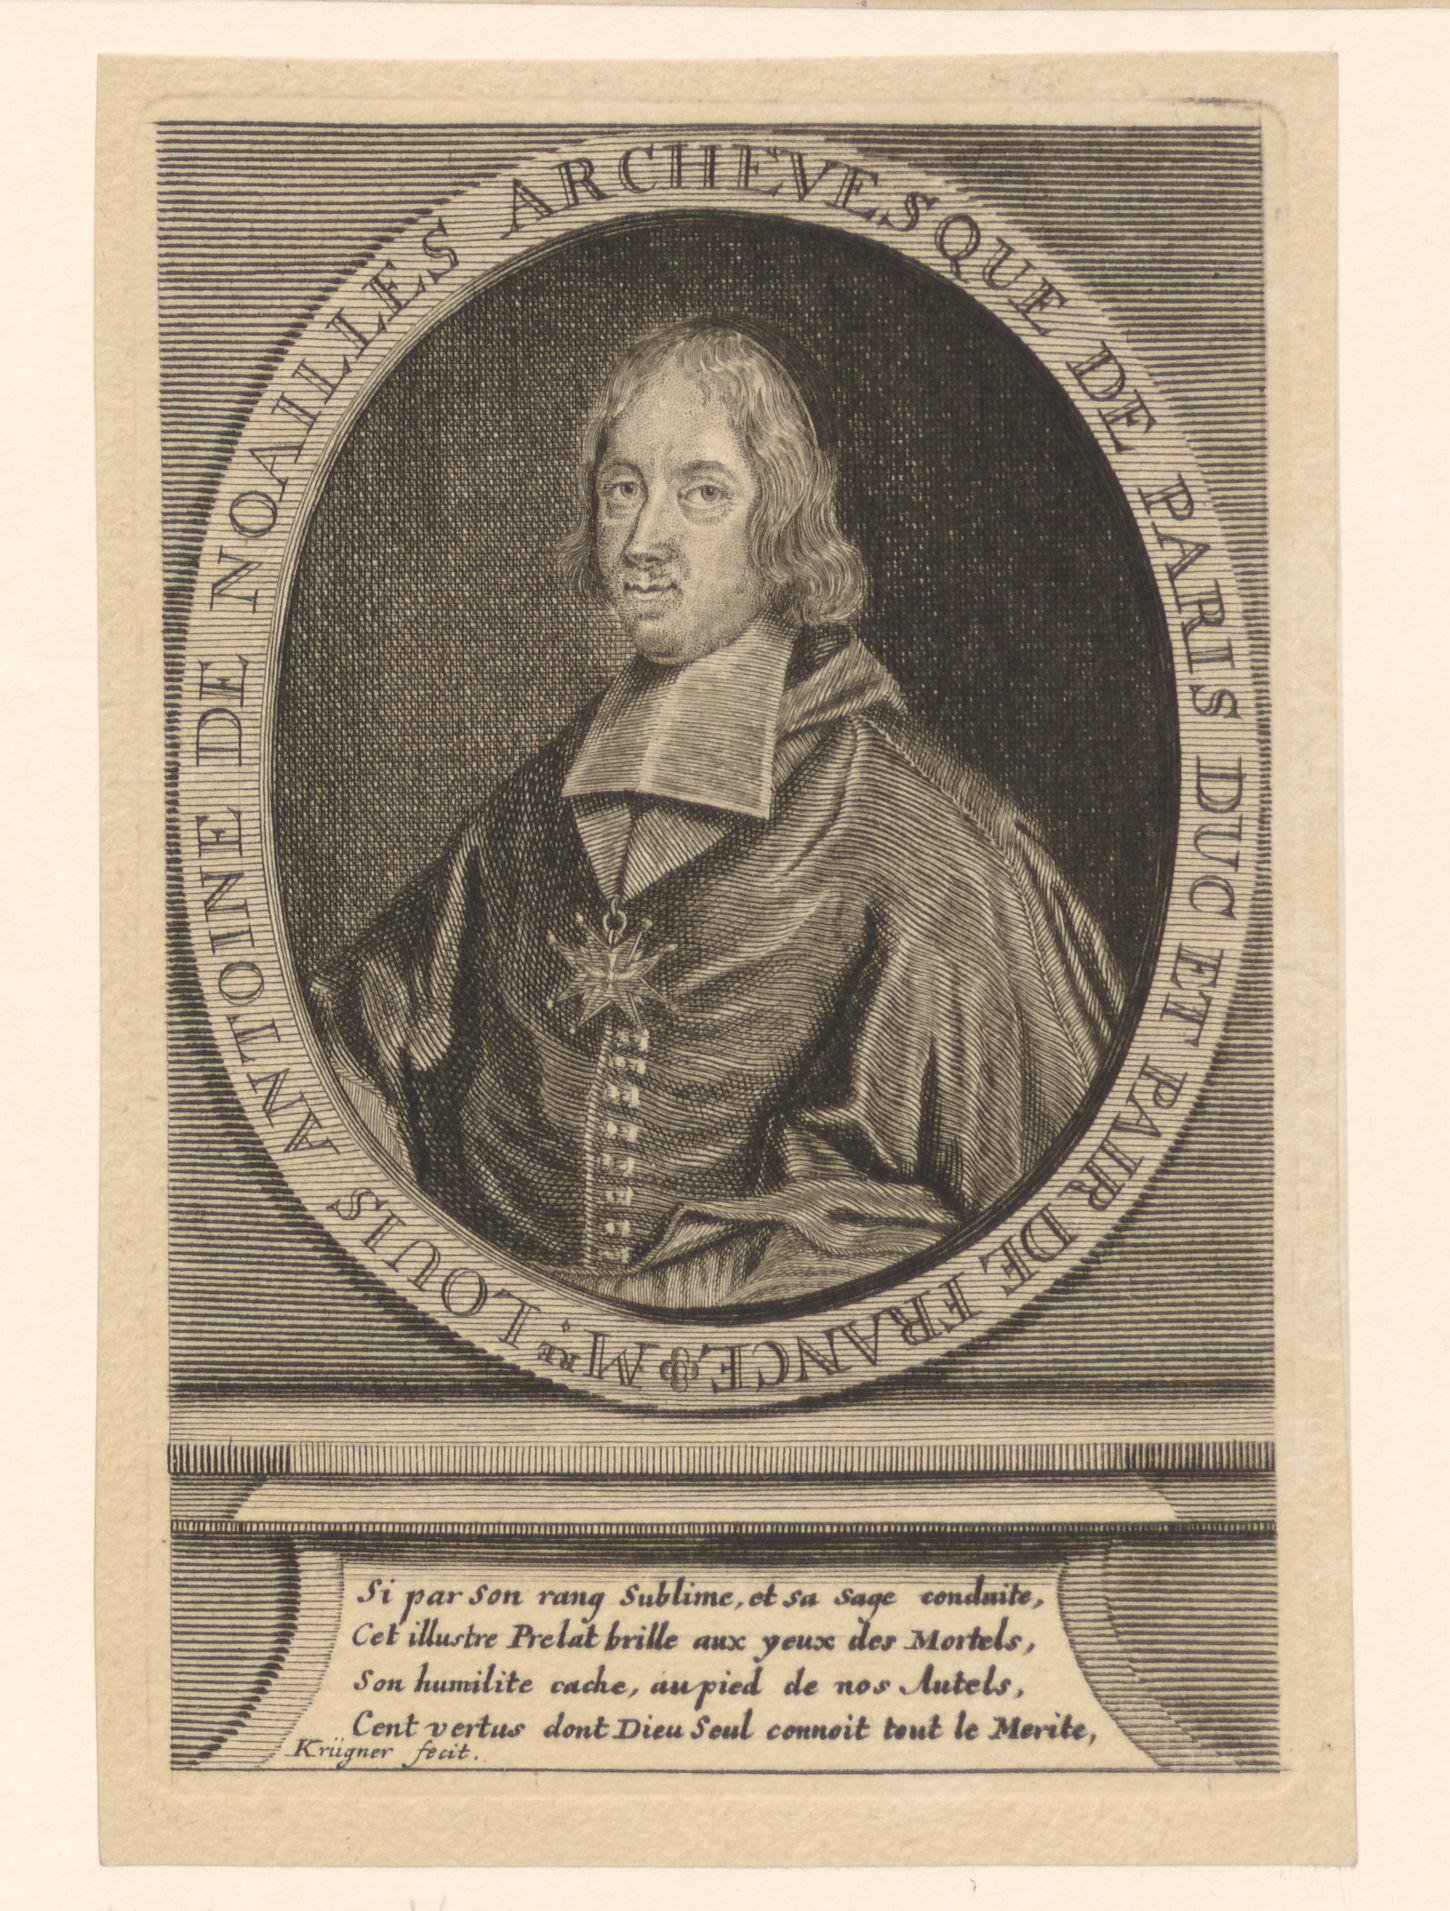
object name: print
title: Portret van Louis-Antoine de Noailles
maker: johann gottfried krügner (i)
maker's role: artist, print maker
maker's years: 1684-1769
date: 1694-1769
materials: paper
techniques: engraving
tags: paris, priest, louis-antoine de noailles, archbishop, bishop, etc. (roman catholic), cardinal, historical persons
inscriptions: collector's mark: Lugt 2228